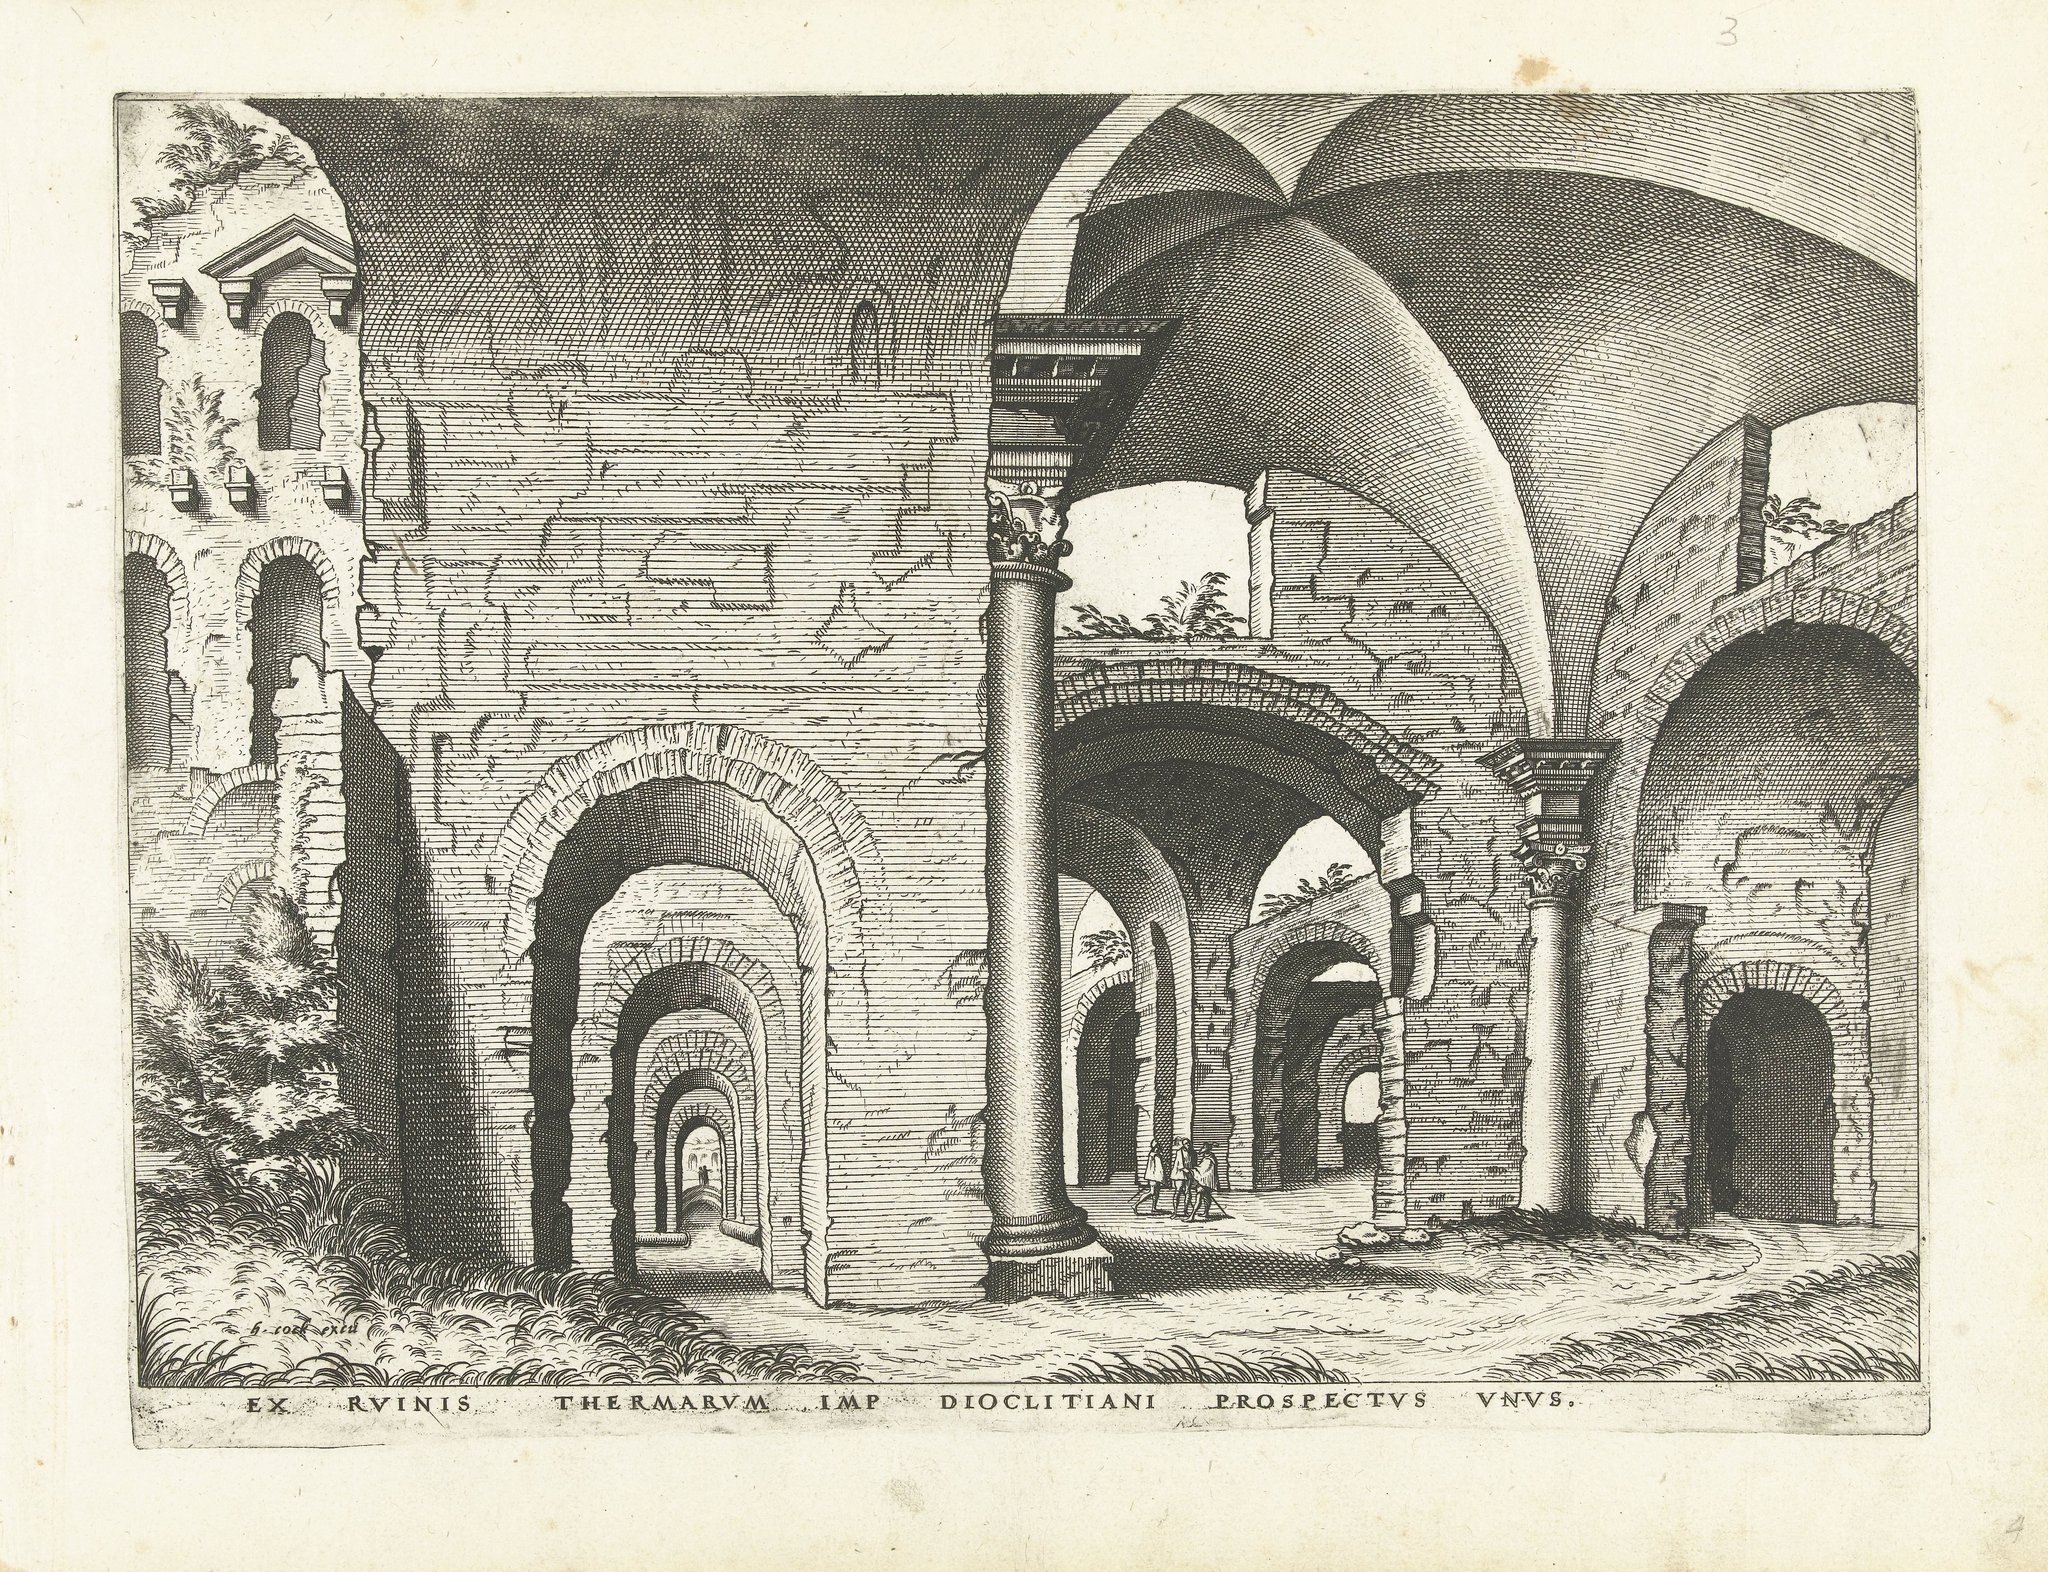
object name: print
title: Gezicht op de Thermen van Diocletianus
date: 1561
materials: paper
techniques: engraving, etching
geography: antwerp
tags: landscape with ruins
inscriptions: collector's mark: Lugt 2760, collector's mark: Lugt 2228, watermark: Briquet 9320-30